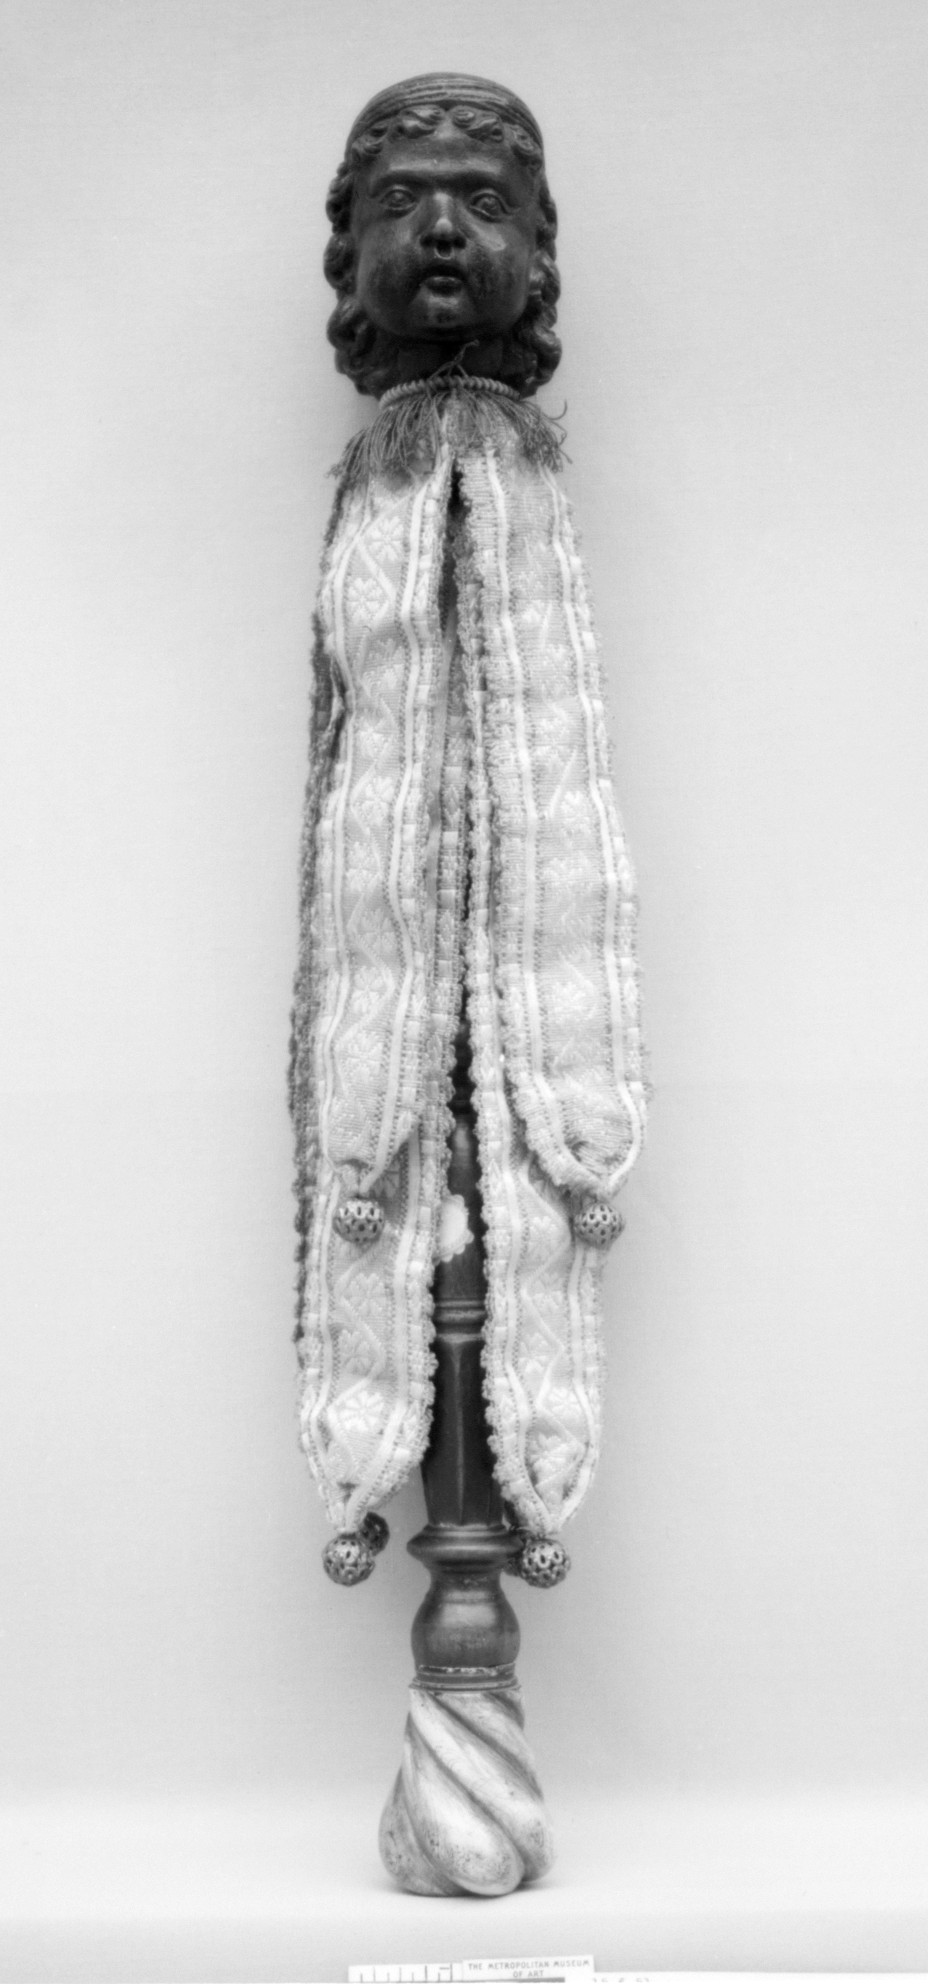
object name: jester's bauble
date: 1601-1700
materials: ivory, ribbon, wood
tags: faces